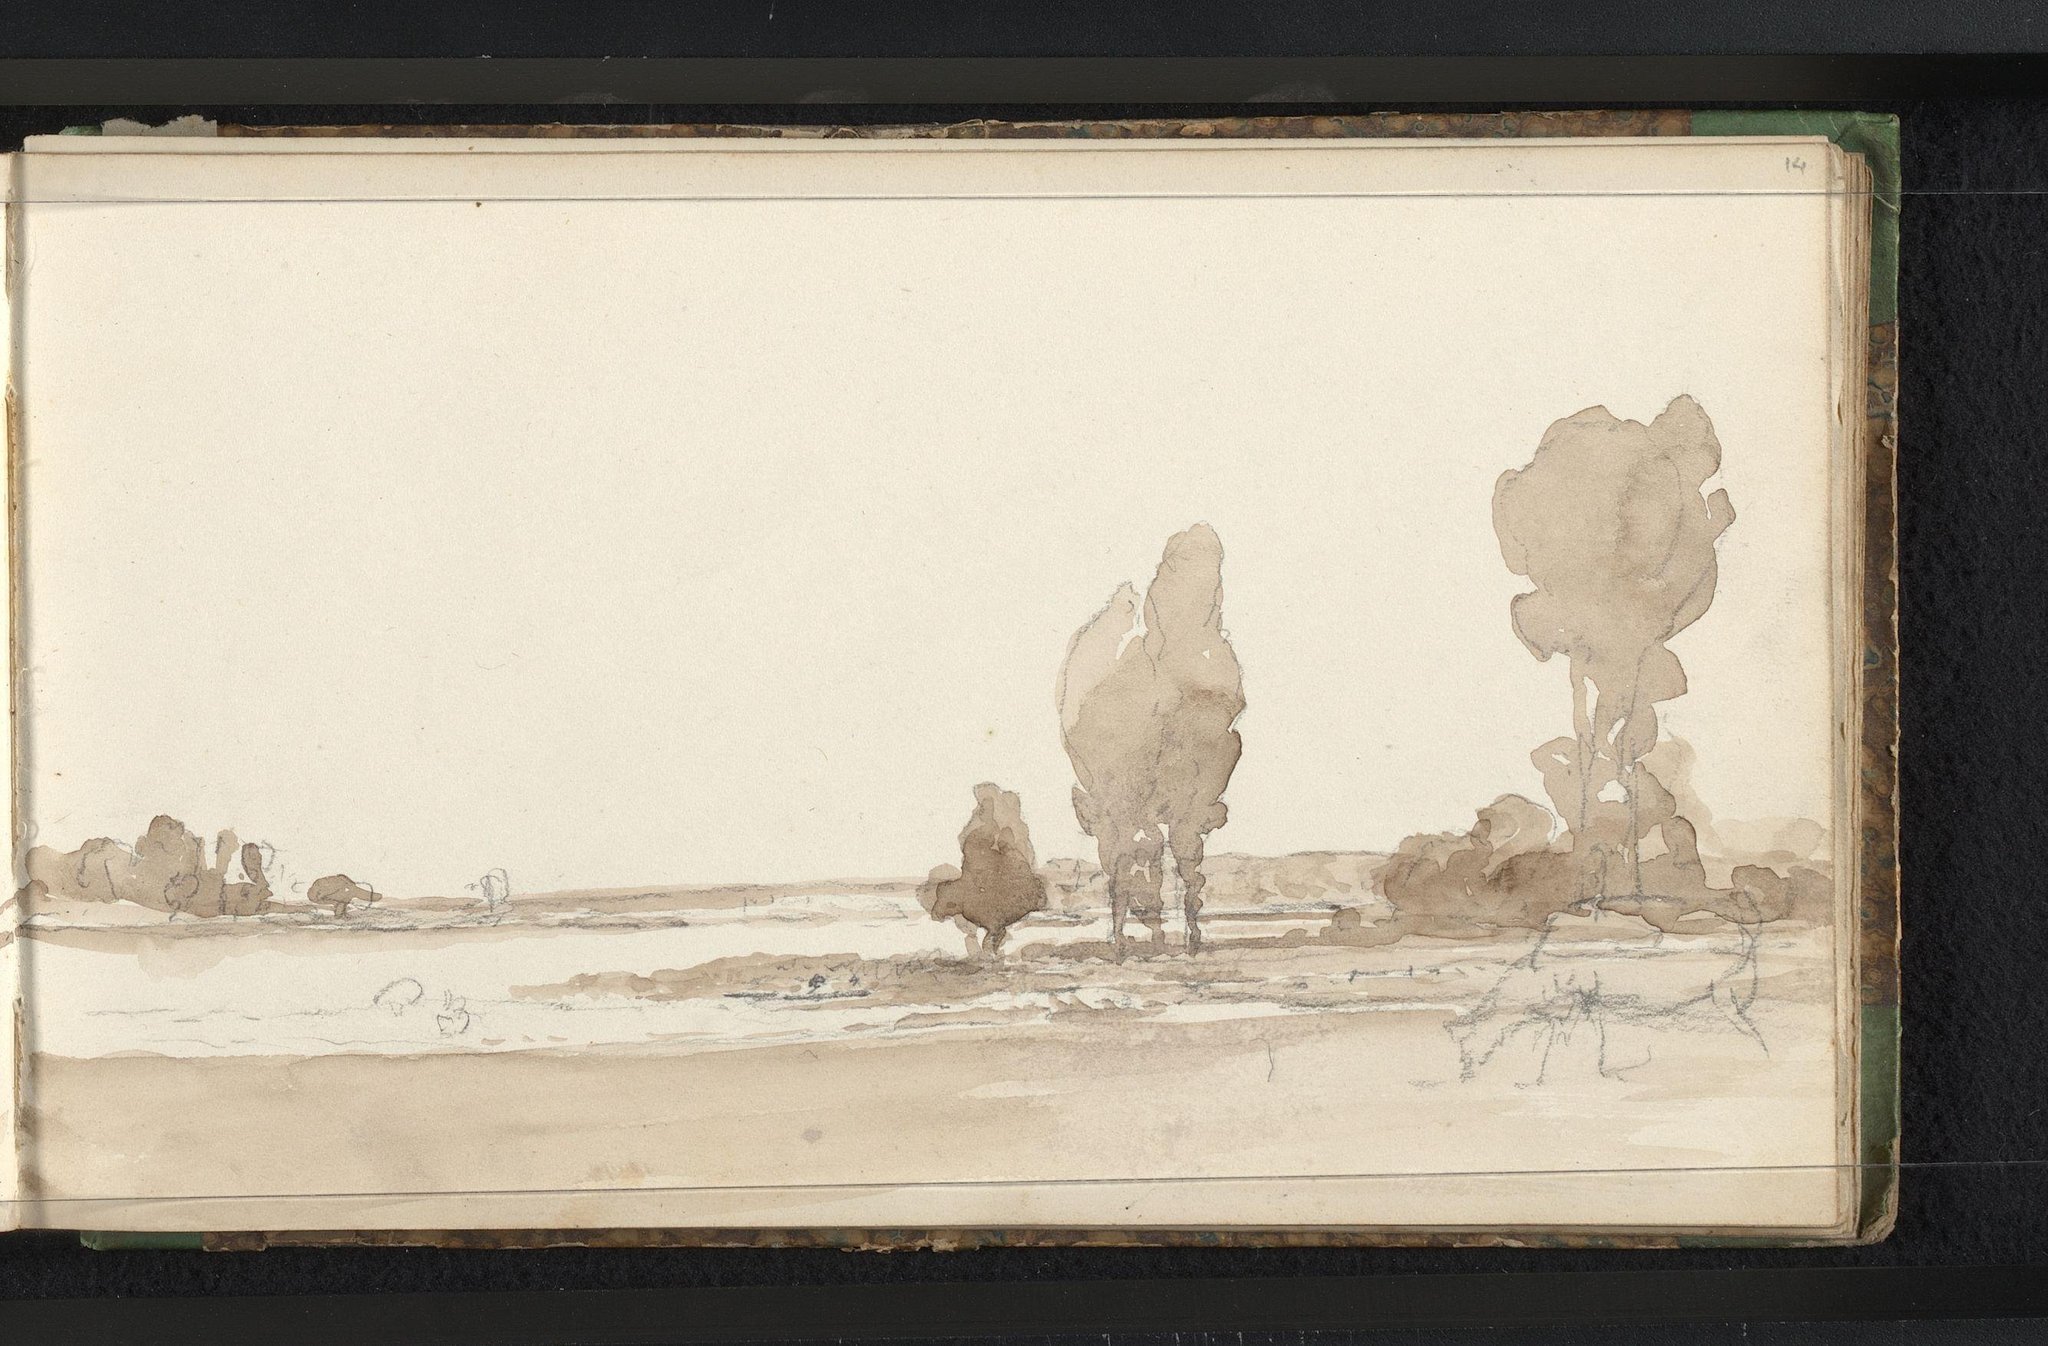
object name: sketchbook leaf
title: Landschap met water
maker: jan bedijs tom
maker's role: draughtsman, painter, print maker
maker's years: 1813-1894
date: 1828-1894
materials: paper, pencil, watercolor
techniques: brush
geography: the hague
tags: trees, landscapes, landscapes with waters, waterscapes, seascapes (in the temperate zone), artist (in general) making preliminary designs, sketching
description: Pagina 14 recto uit een schetsboek met 50 bladen.